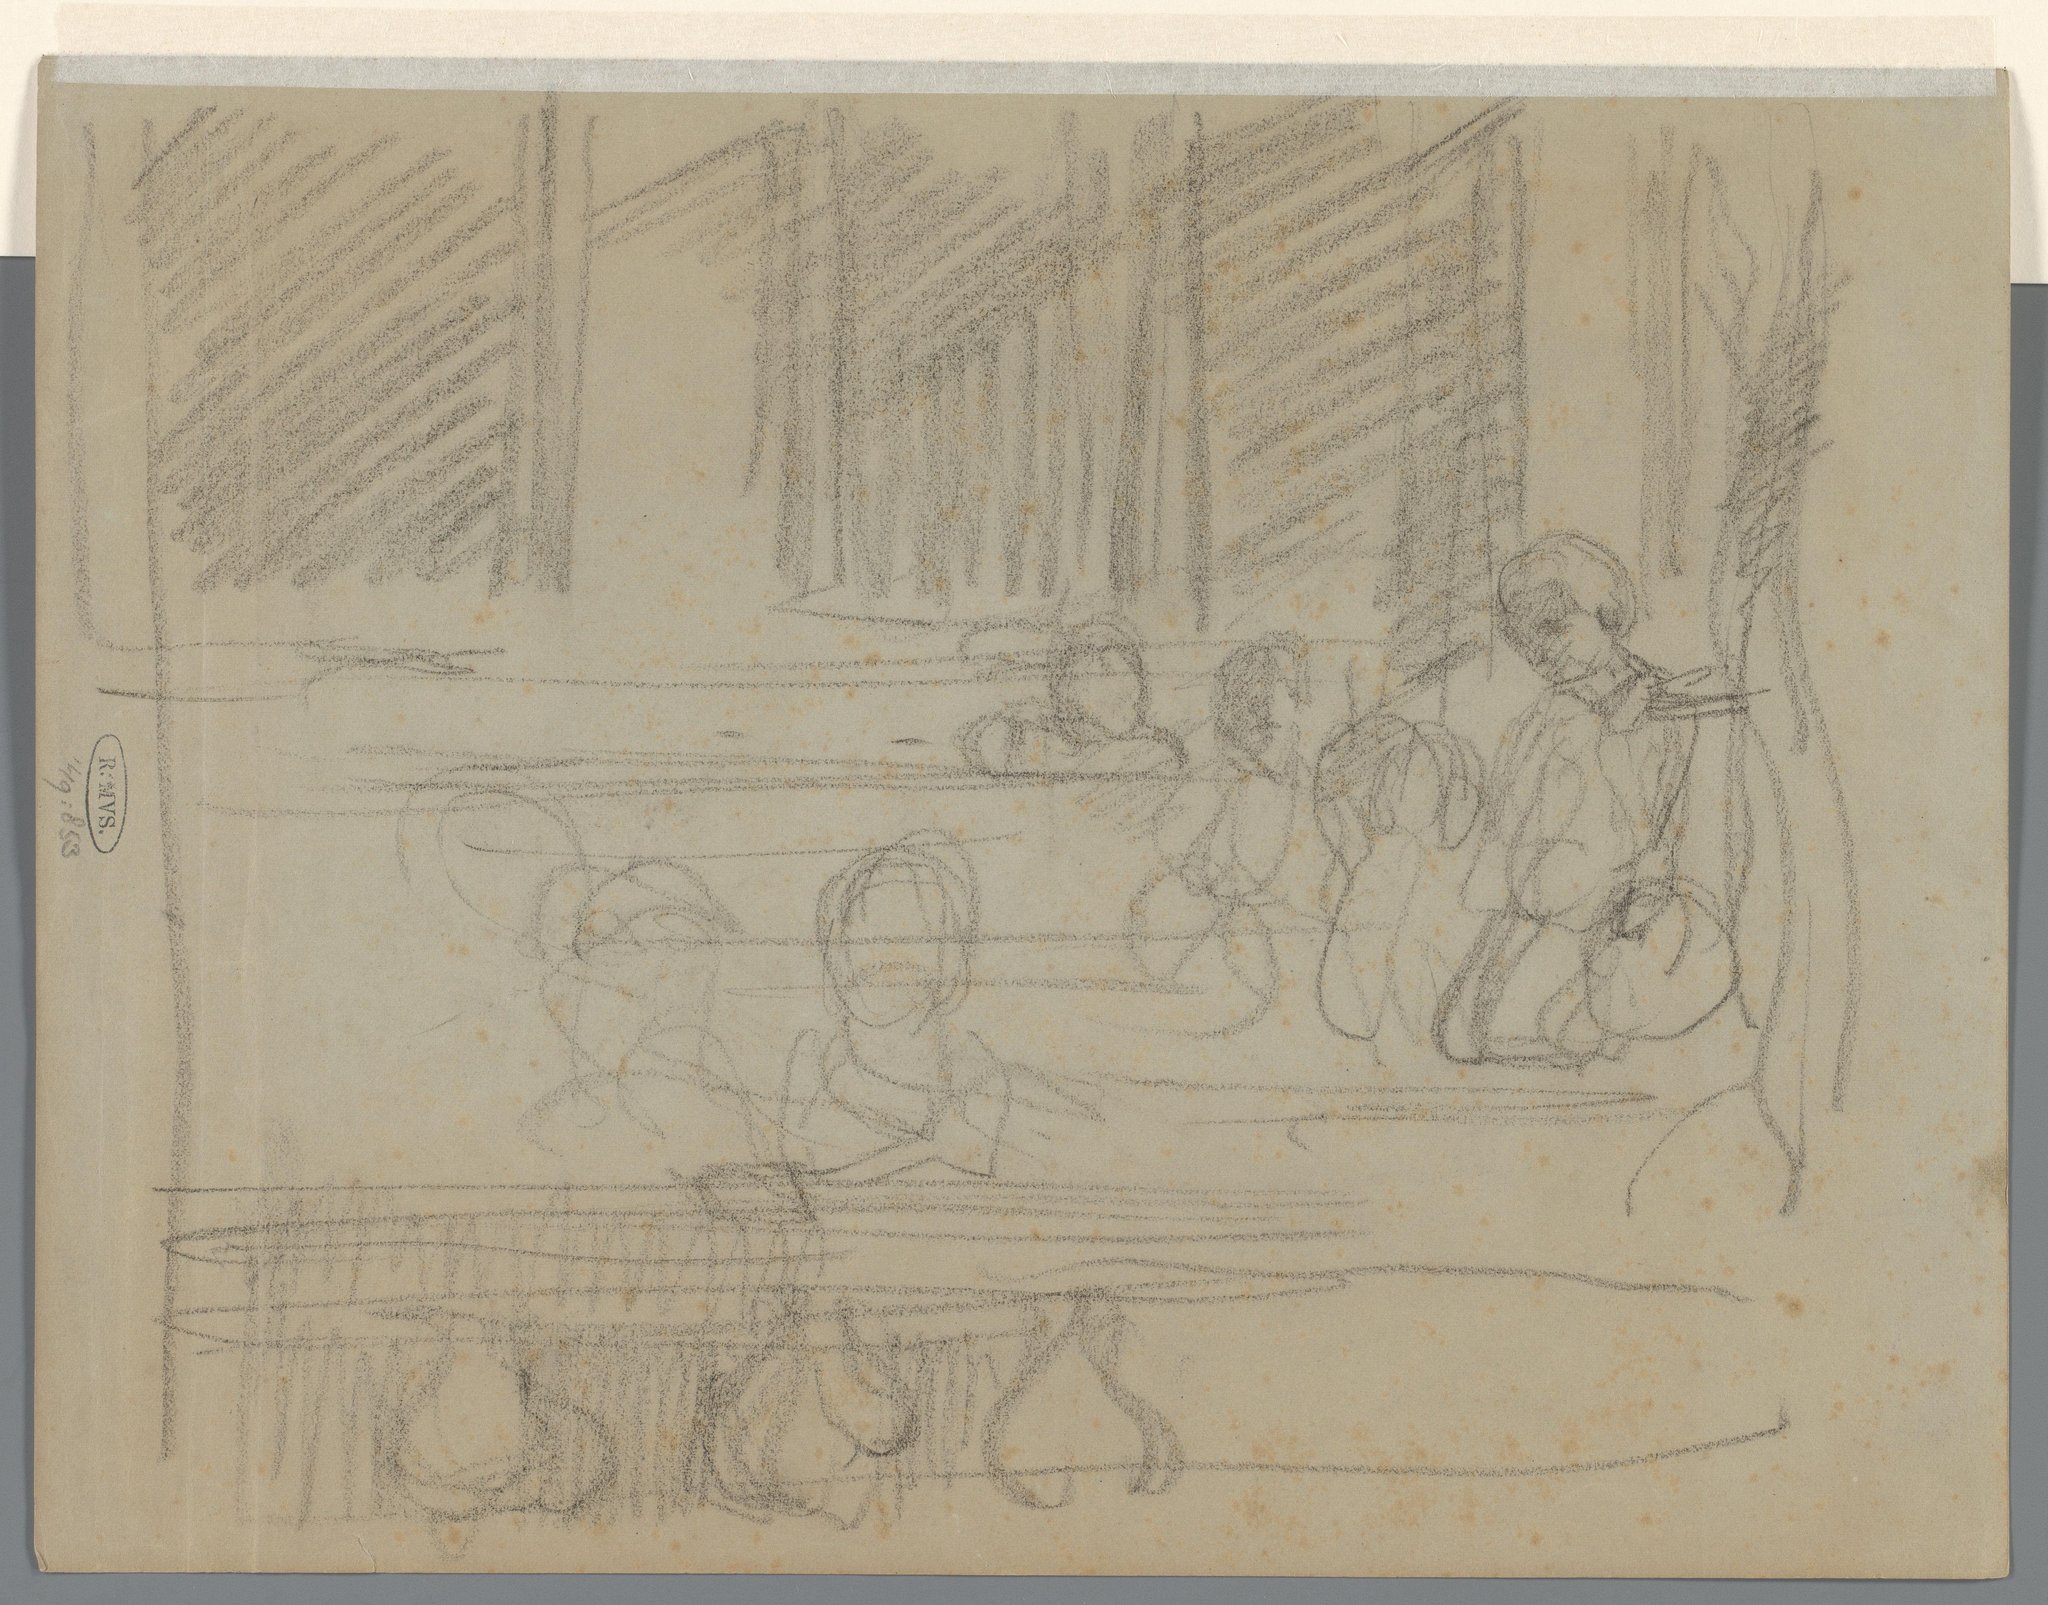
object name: drawing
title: Schets van een klaslokaal, met kinderen in de banken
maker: august allebé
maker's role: draughtsman, print maker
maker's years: 1838-1927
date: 1848-1927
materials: chalk, paper